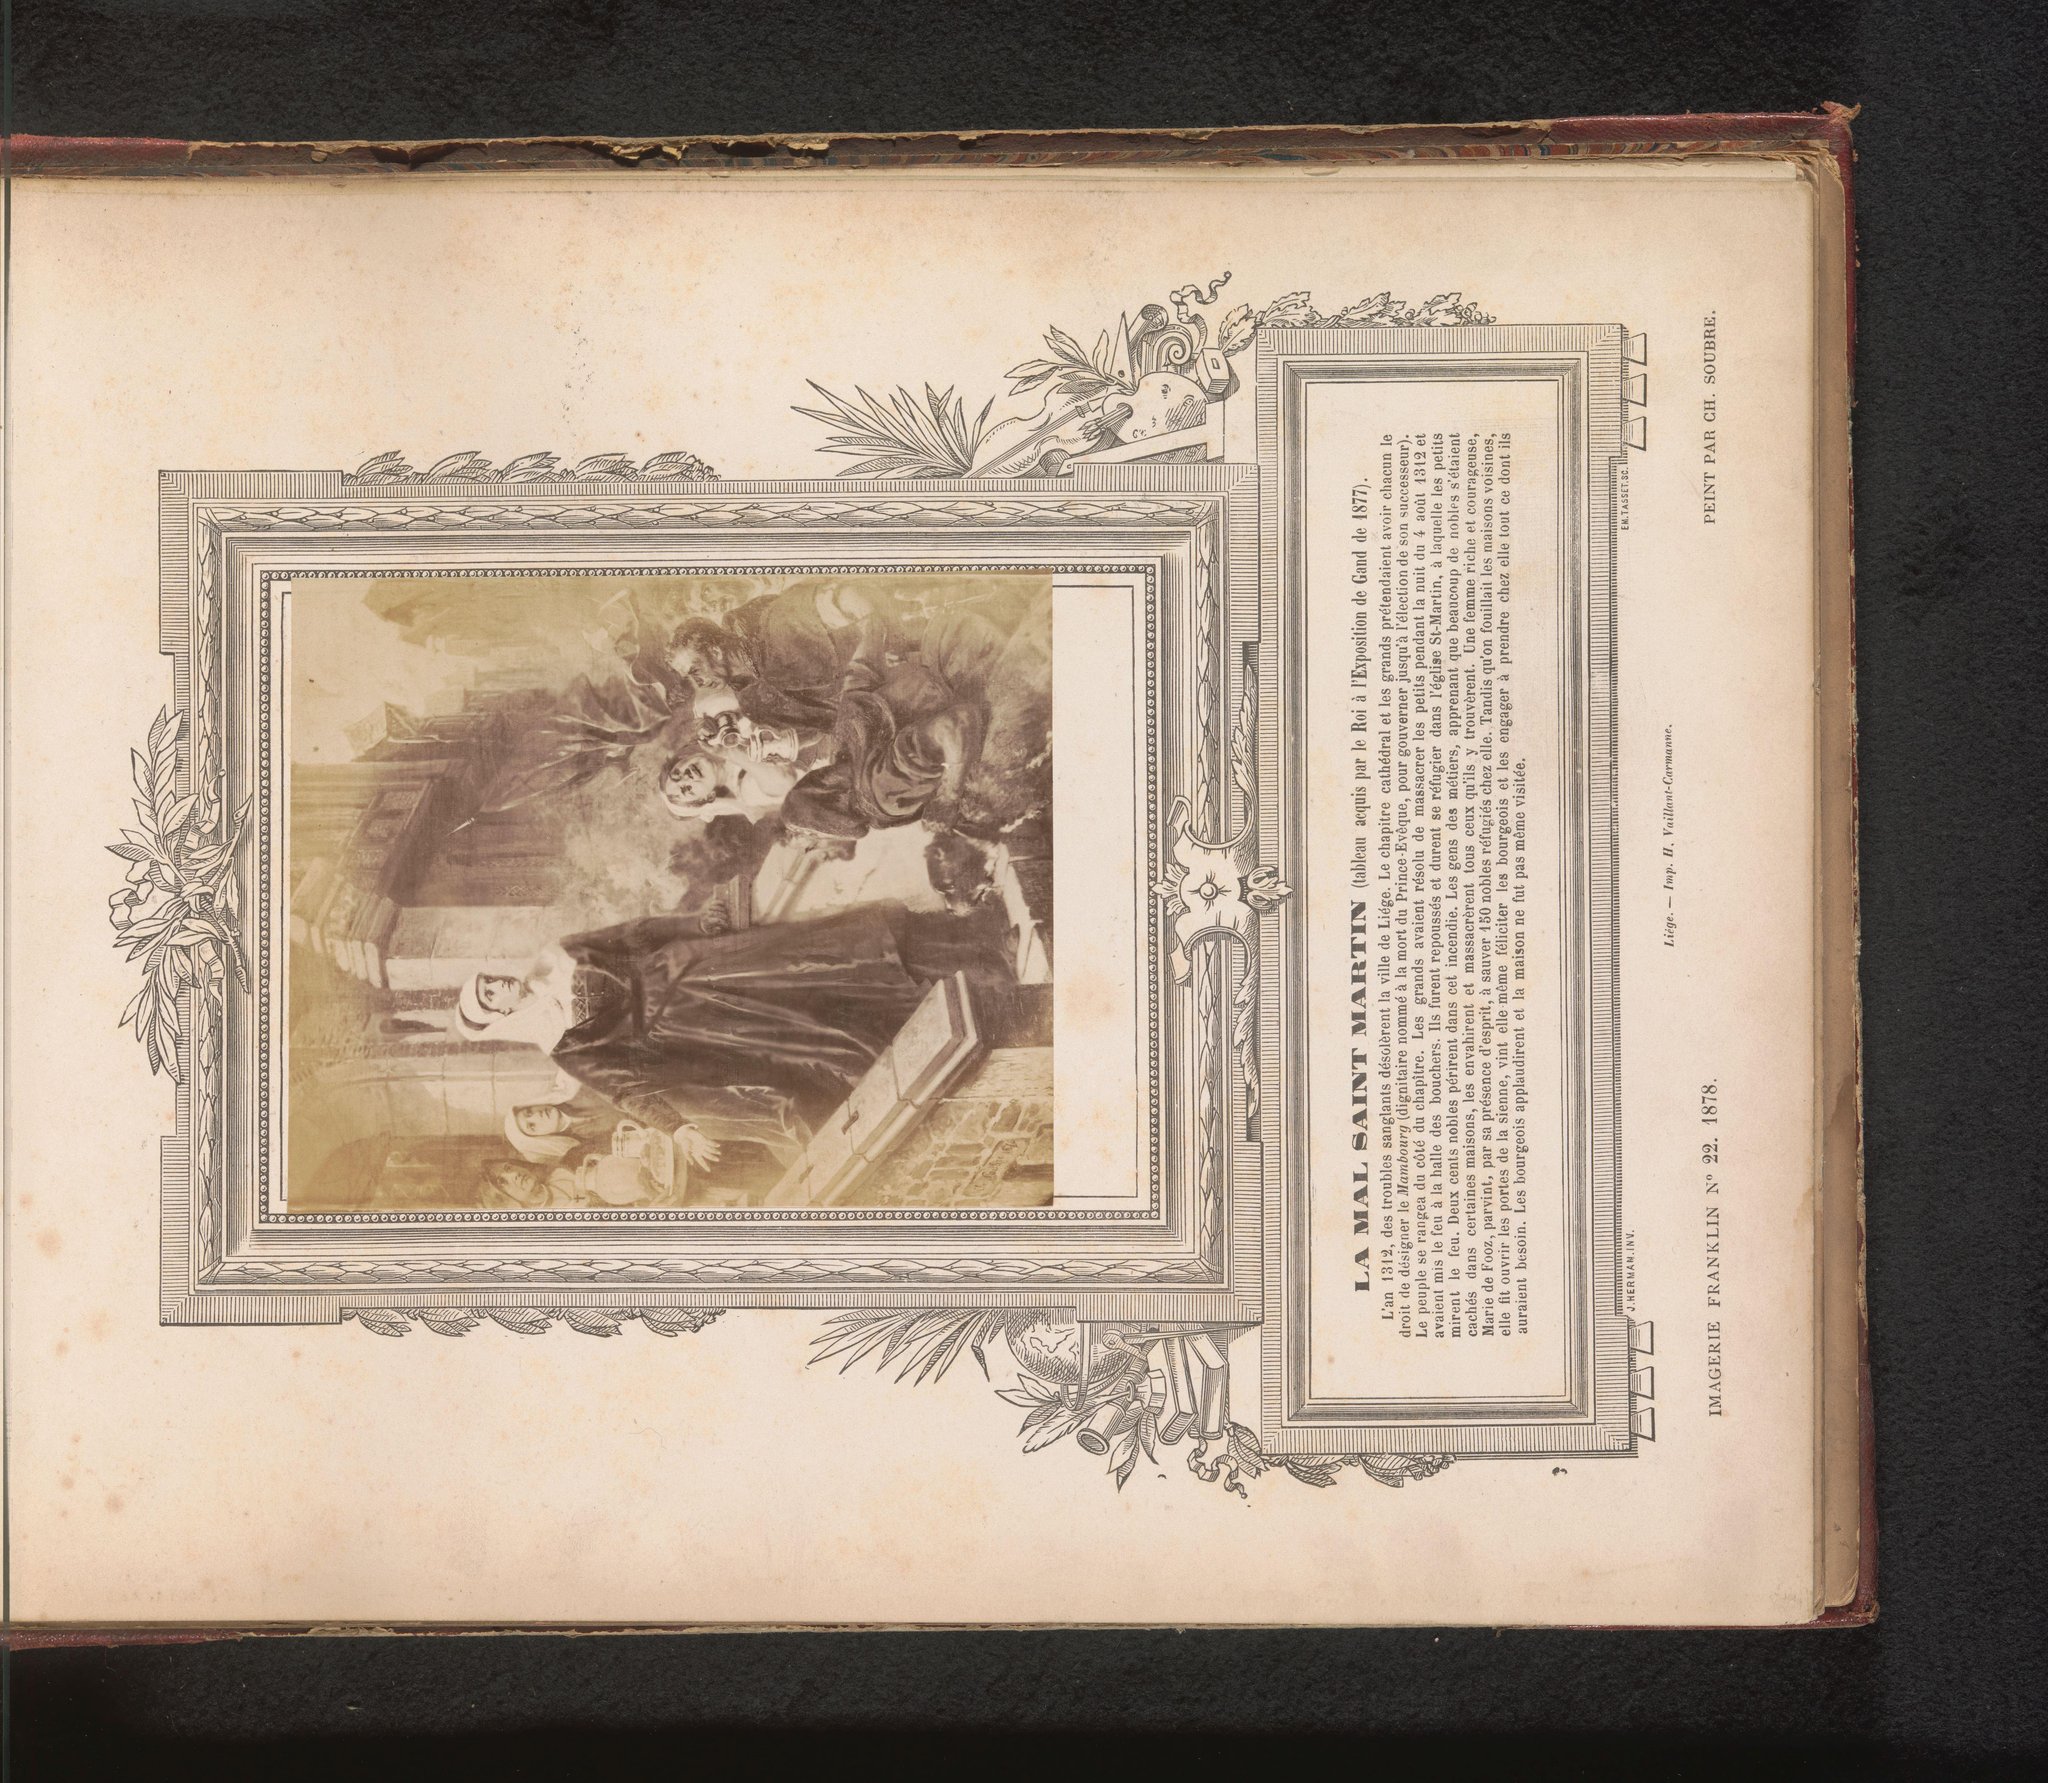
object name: photograph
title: Fotoreproductie van Le Mal Saint Martin door Charles Soubre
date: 1873-1878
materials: photographic support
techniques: albumen print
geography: liège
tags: church (exterior), burning as process, liège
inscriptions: name: ‘EM. TASSET, SC.’, name: ‘J. HERMAN, INV.’, inscription: ‘(tableu acquis (...) même visitée.’, inscription: ‘IMAGERIE FRANKLIN No 22. - 1878.’